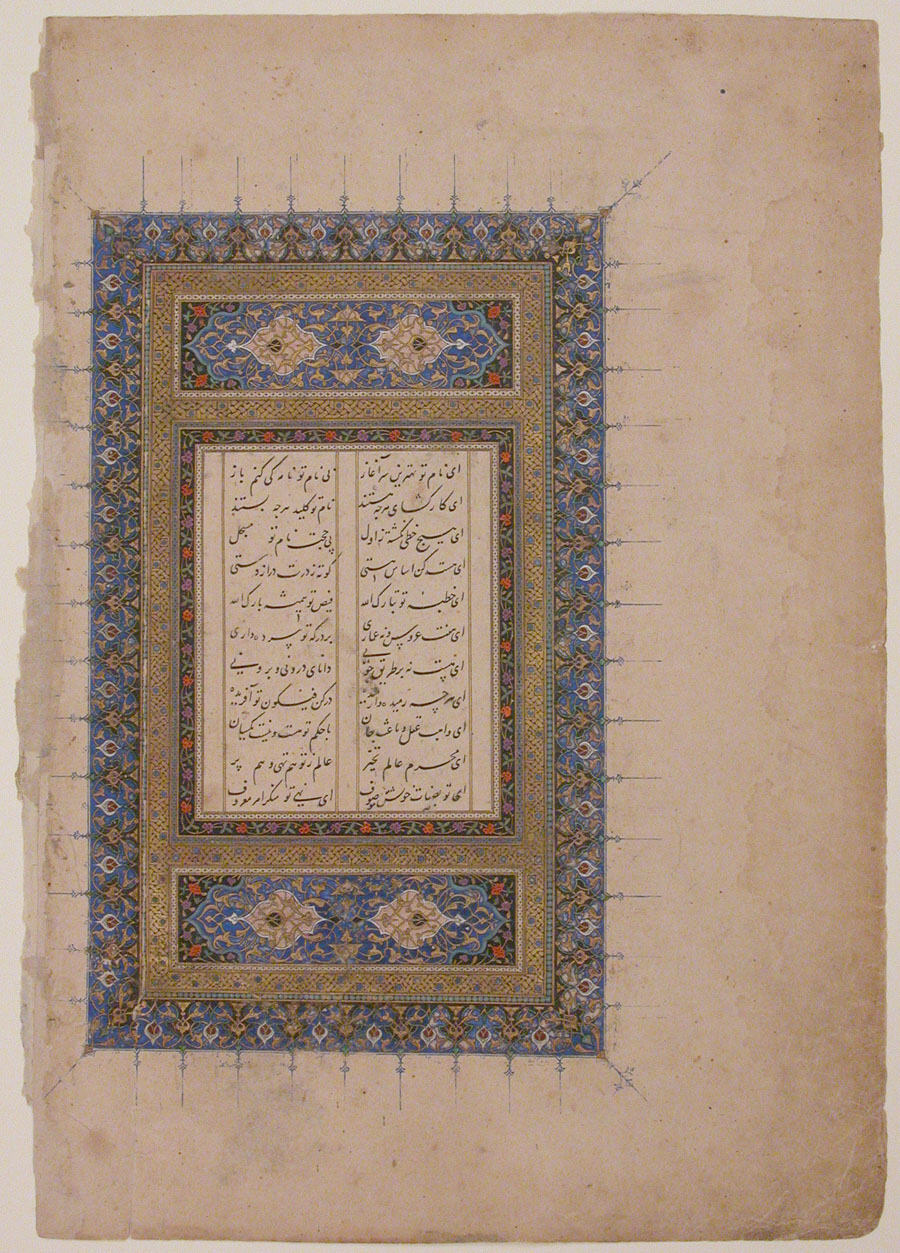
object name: folio from an illustrated manuscript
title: Illuminated Opening Page Titled Laila and Majnun from a Khamsa (Quintet) of Nizami of Ganja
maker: ja'far baisunghuri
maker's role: calligrapher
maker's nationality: iranian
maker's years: 1400-1460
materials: gold, ink, paper, watercolor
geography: afghanistan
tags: calligraphy